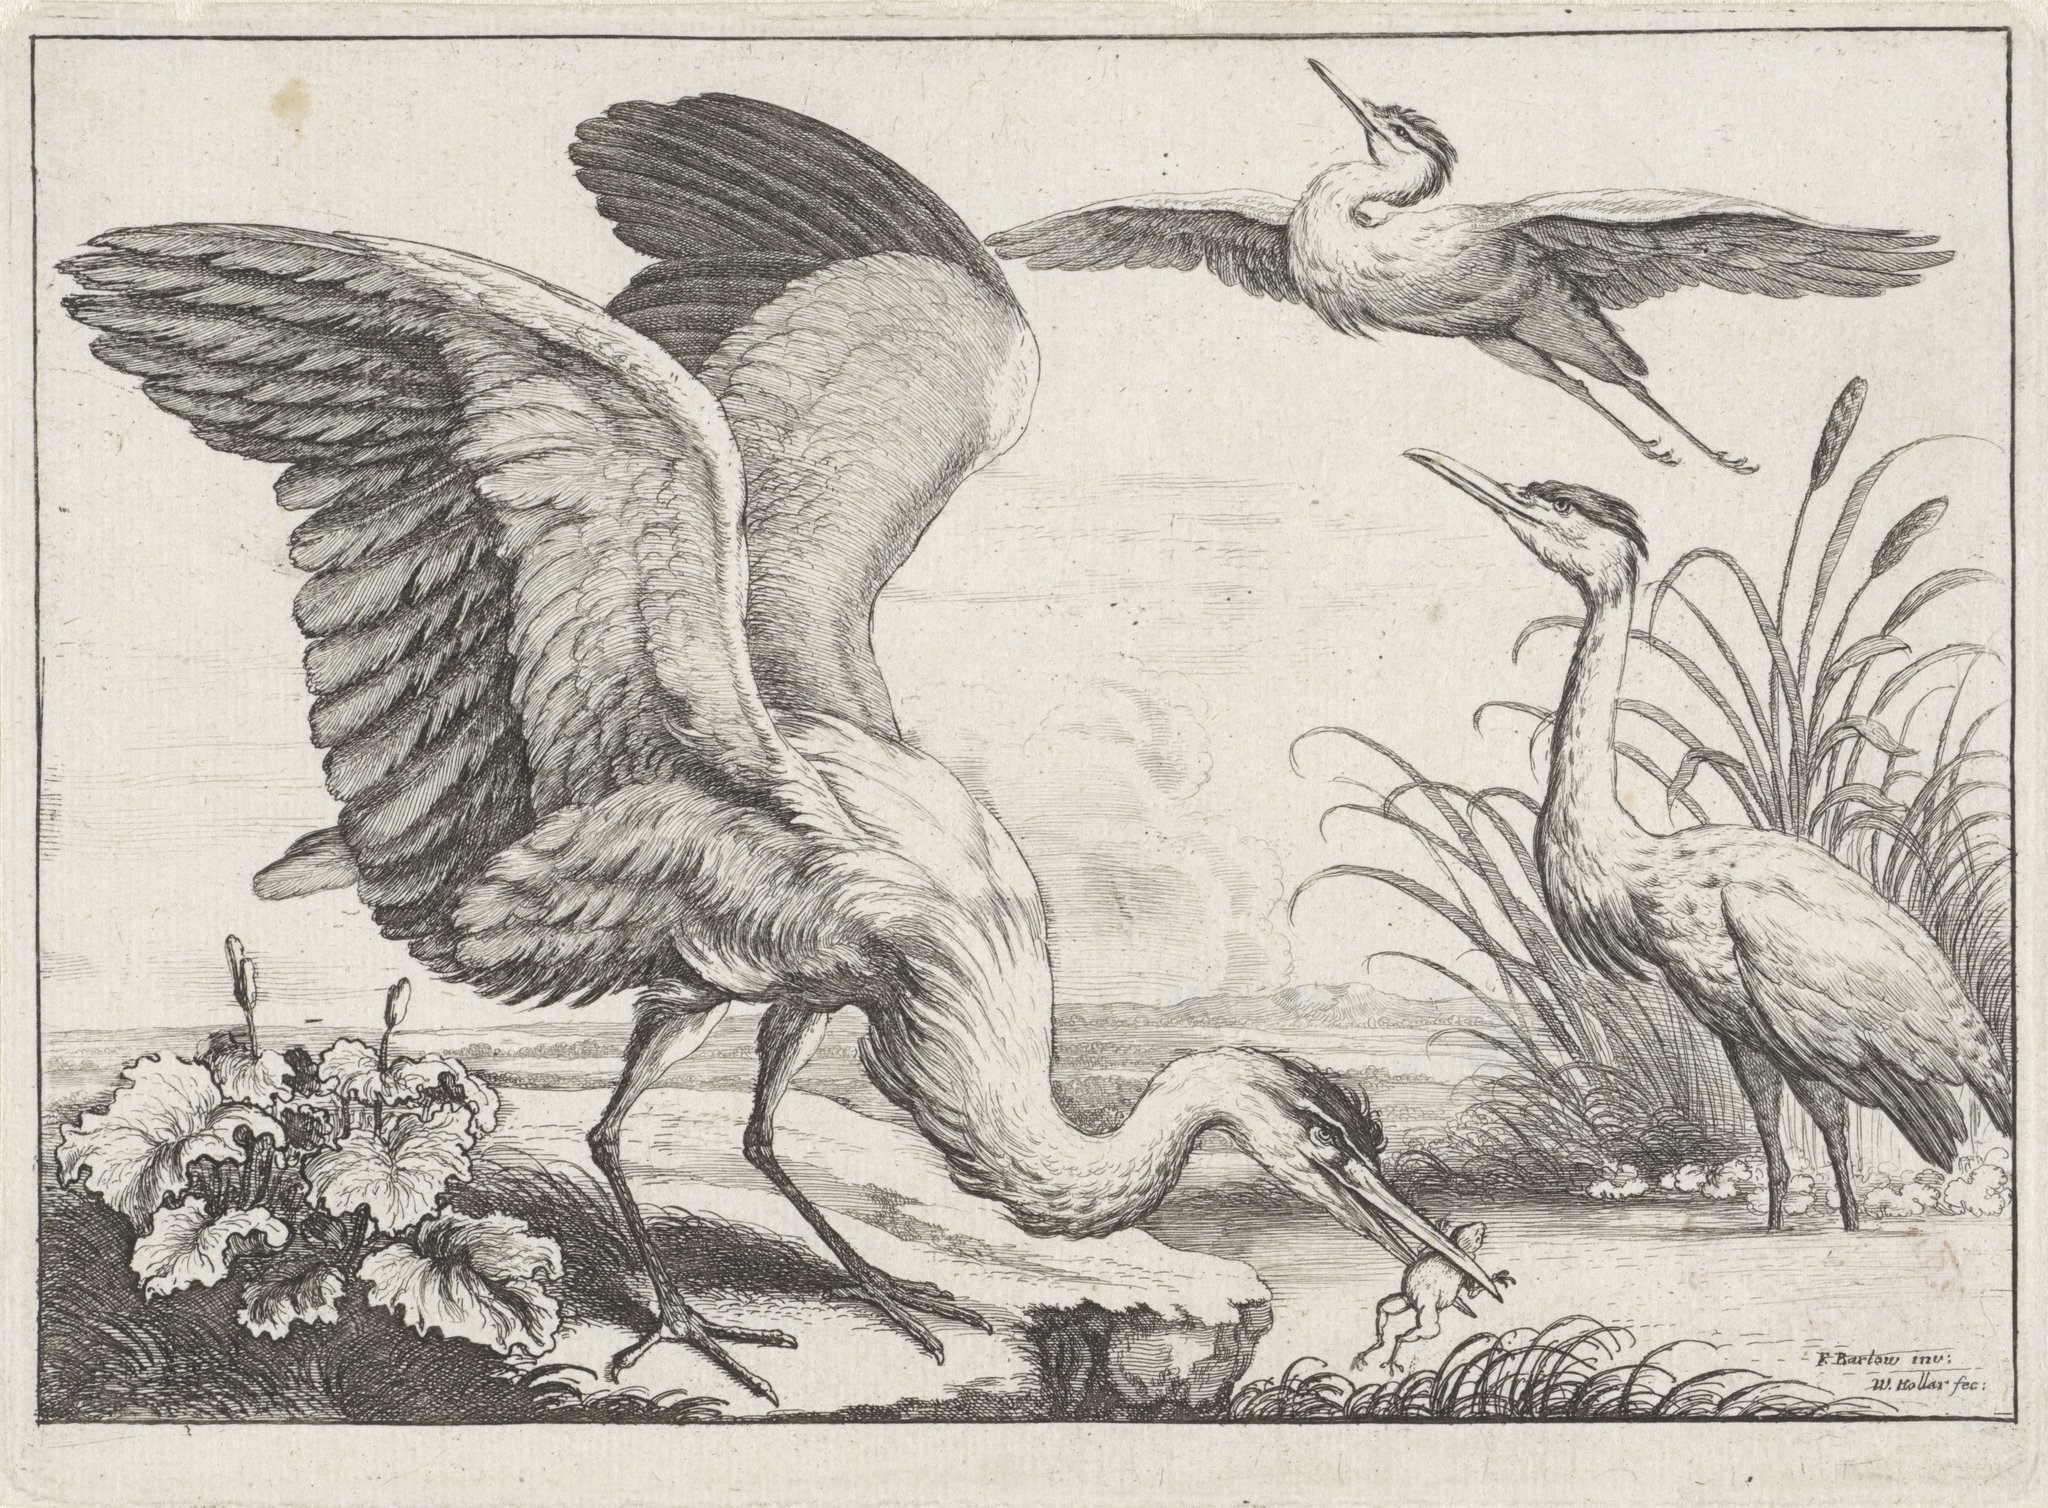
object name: print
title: Verschillende vogels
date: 1654-1662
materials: paper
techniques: etching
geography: england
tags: shore-birds and wading-birds: heron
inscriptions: collector's mark: Lugt 240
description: Prent maakt deel uit van de negendelige serie met voorstellingen van verschillende vogels: "Diversae avium species".